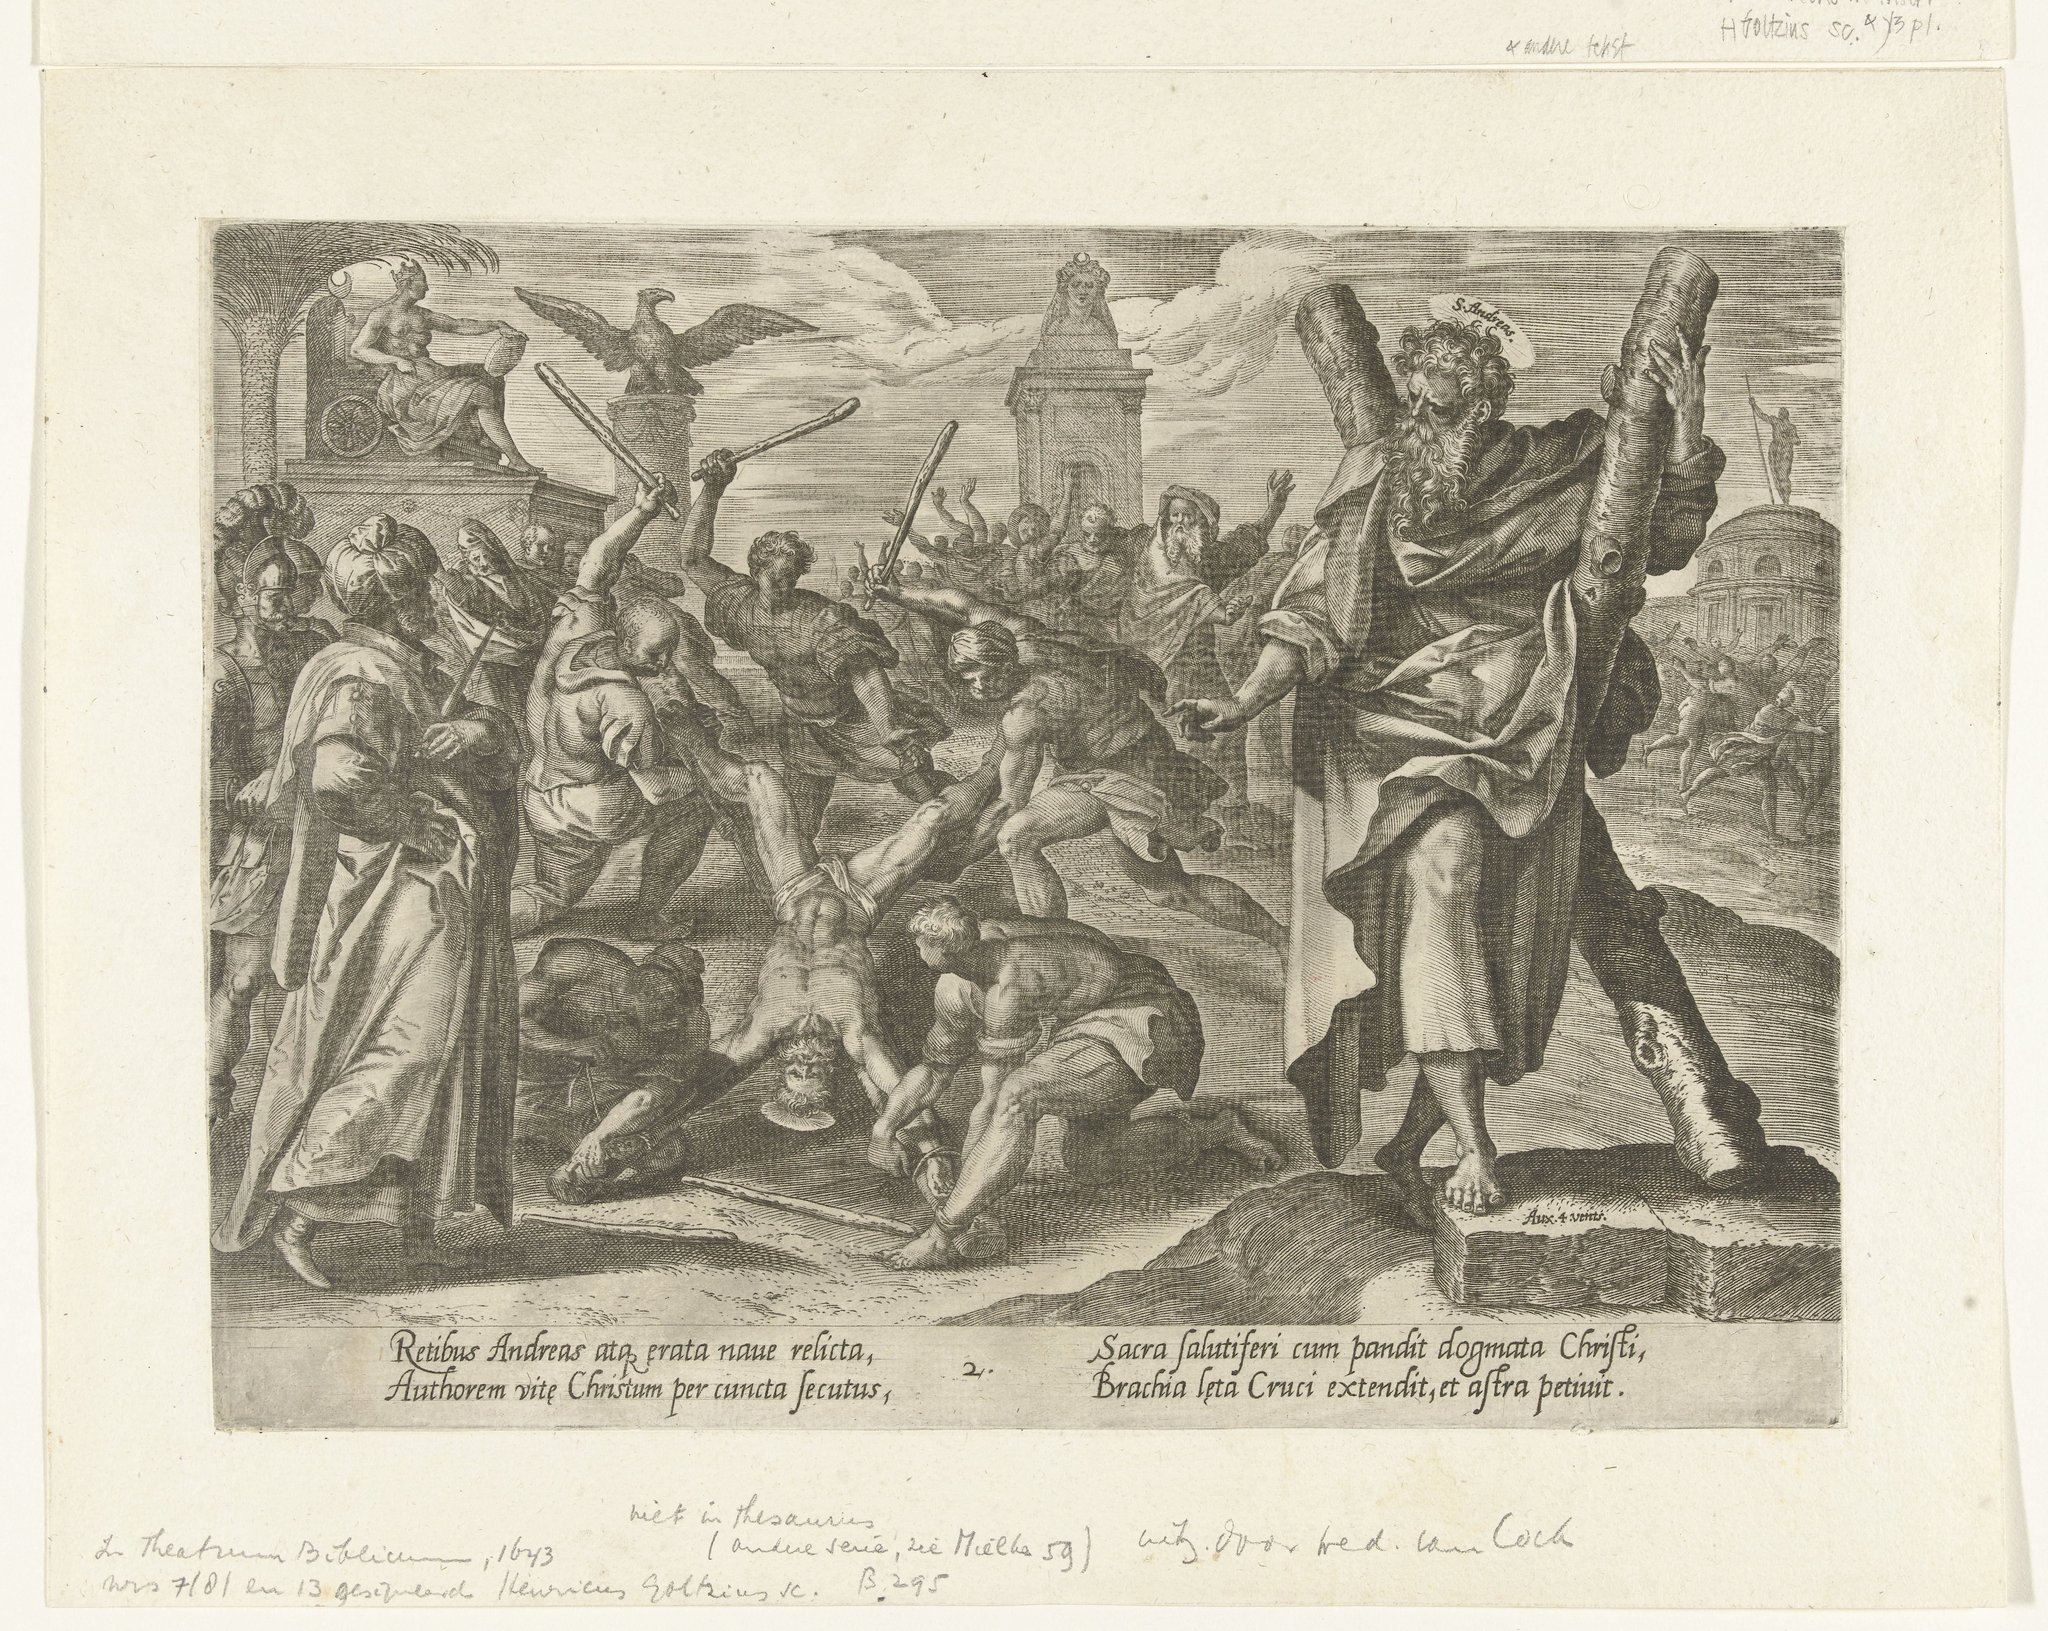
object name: print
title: Het martelaarschap van Christus en de apostelen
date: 1577-1582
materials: paper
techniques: engraving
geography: antwerp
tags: crucifixion of andrew: he is undressed and tied to the cross, the apostle andrew; possible attributes: book, x-shaped cross, fish, fishing-net, rope, scroll - martyrdom, suffering, misfortune, death of male saint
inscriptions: collector's mark: Lugt 240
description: Andreas wordt gekruisigd op een X-vormig kruis; rechts naast het tafereel van zijn marteldood staat hij nogmaals afgebeeld, met zijn Andreaskruis. Onder de voorstelling tweemaal twee regels Latijn. Deze prent is onderdeel van een serie van 13 prenten van Christus (ongenummerd) en de apostelen (genummerd), meer specifiek van de martelingen die ze hebben ondergaan.